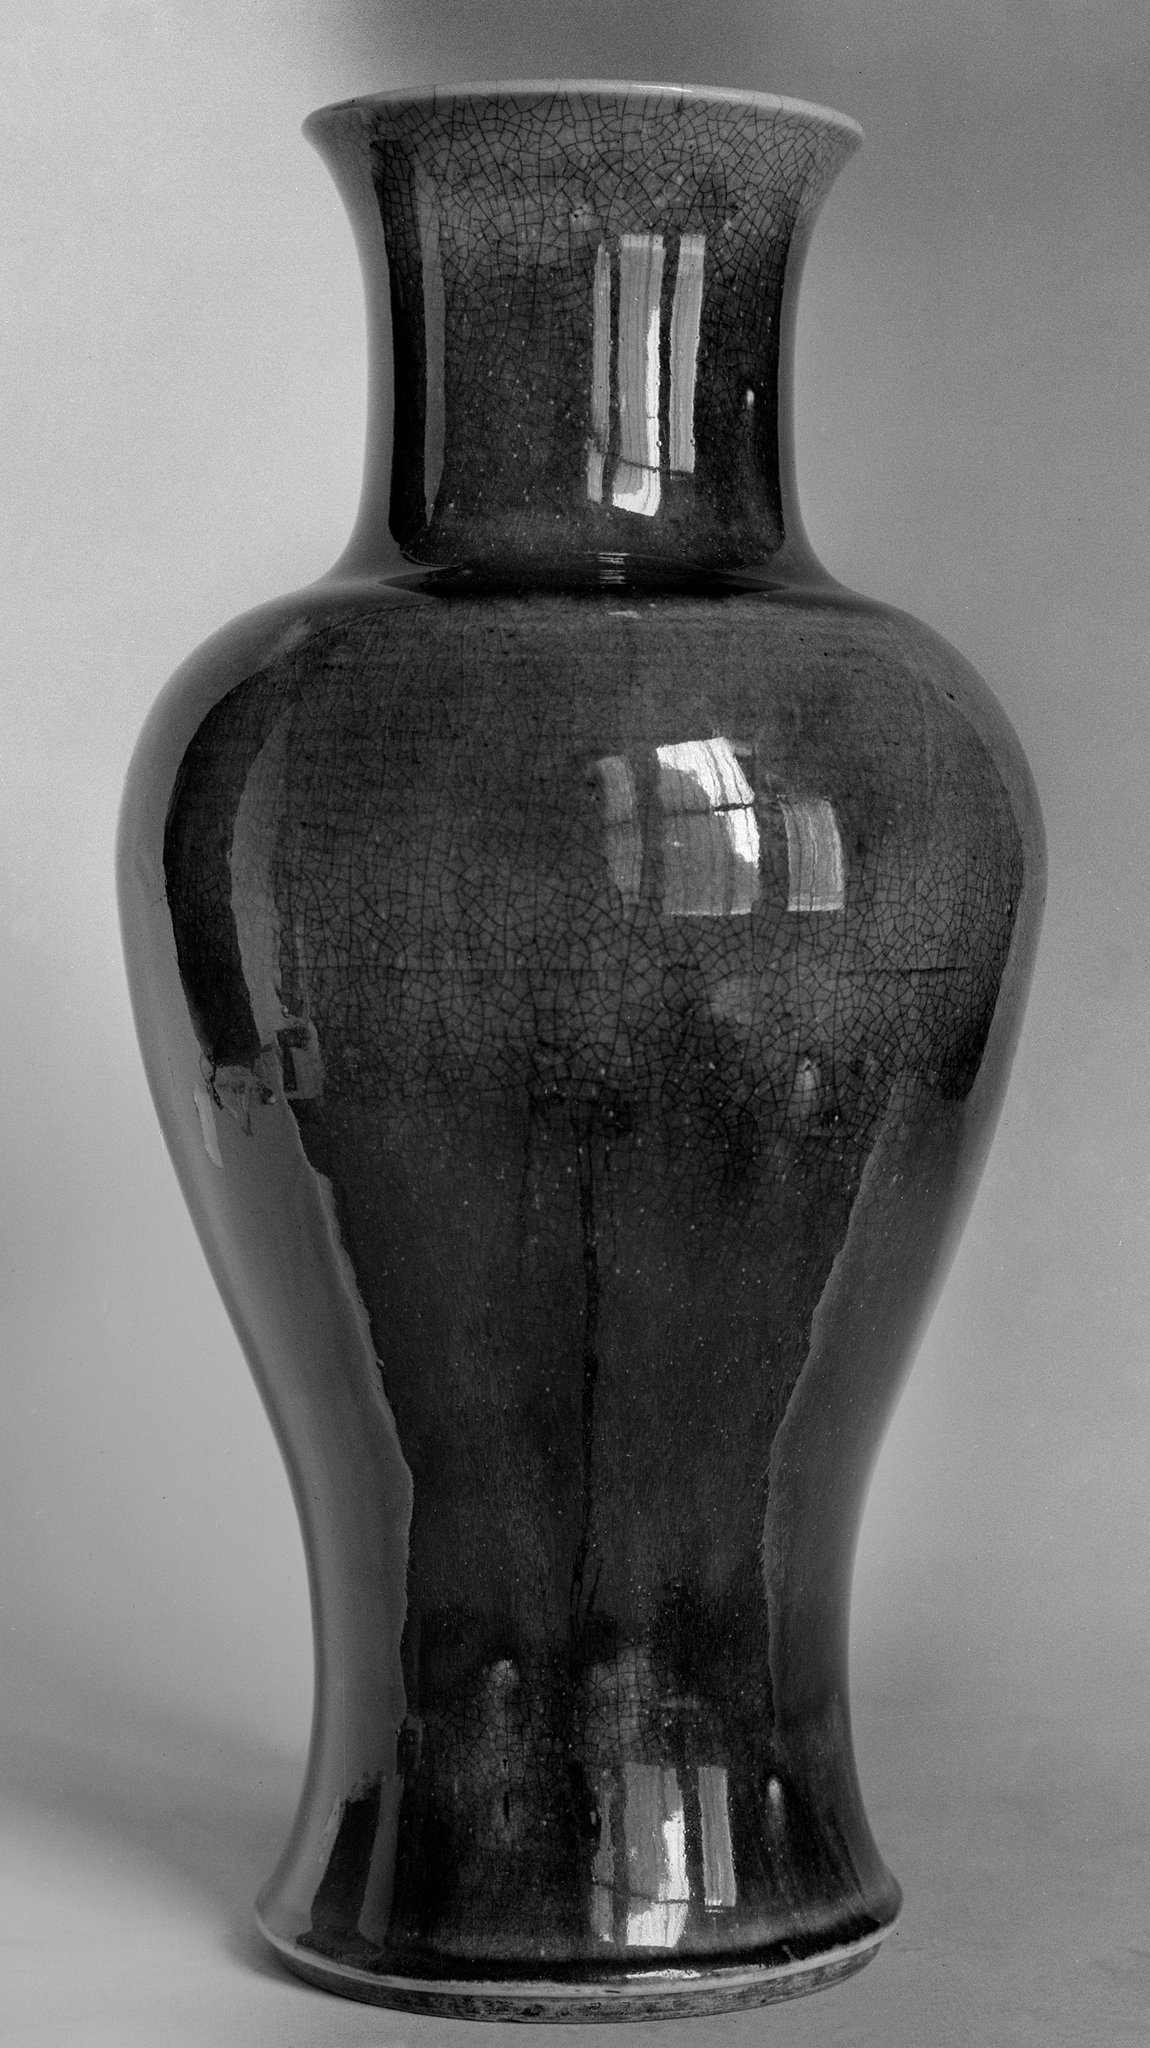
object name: vase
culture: chinese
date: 1662-1722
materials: porcelain